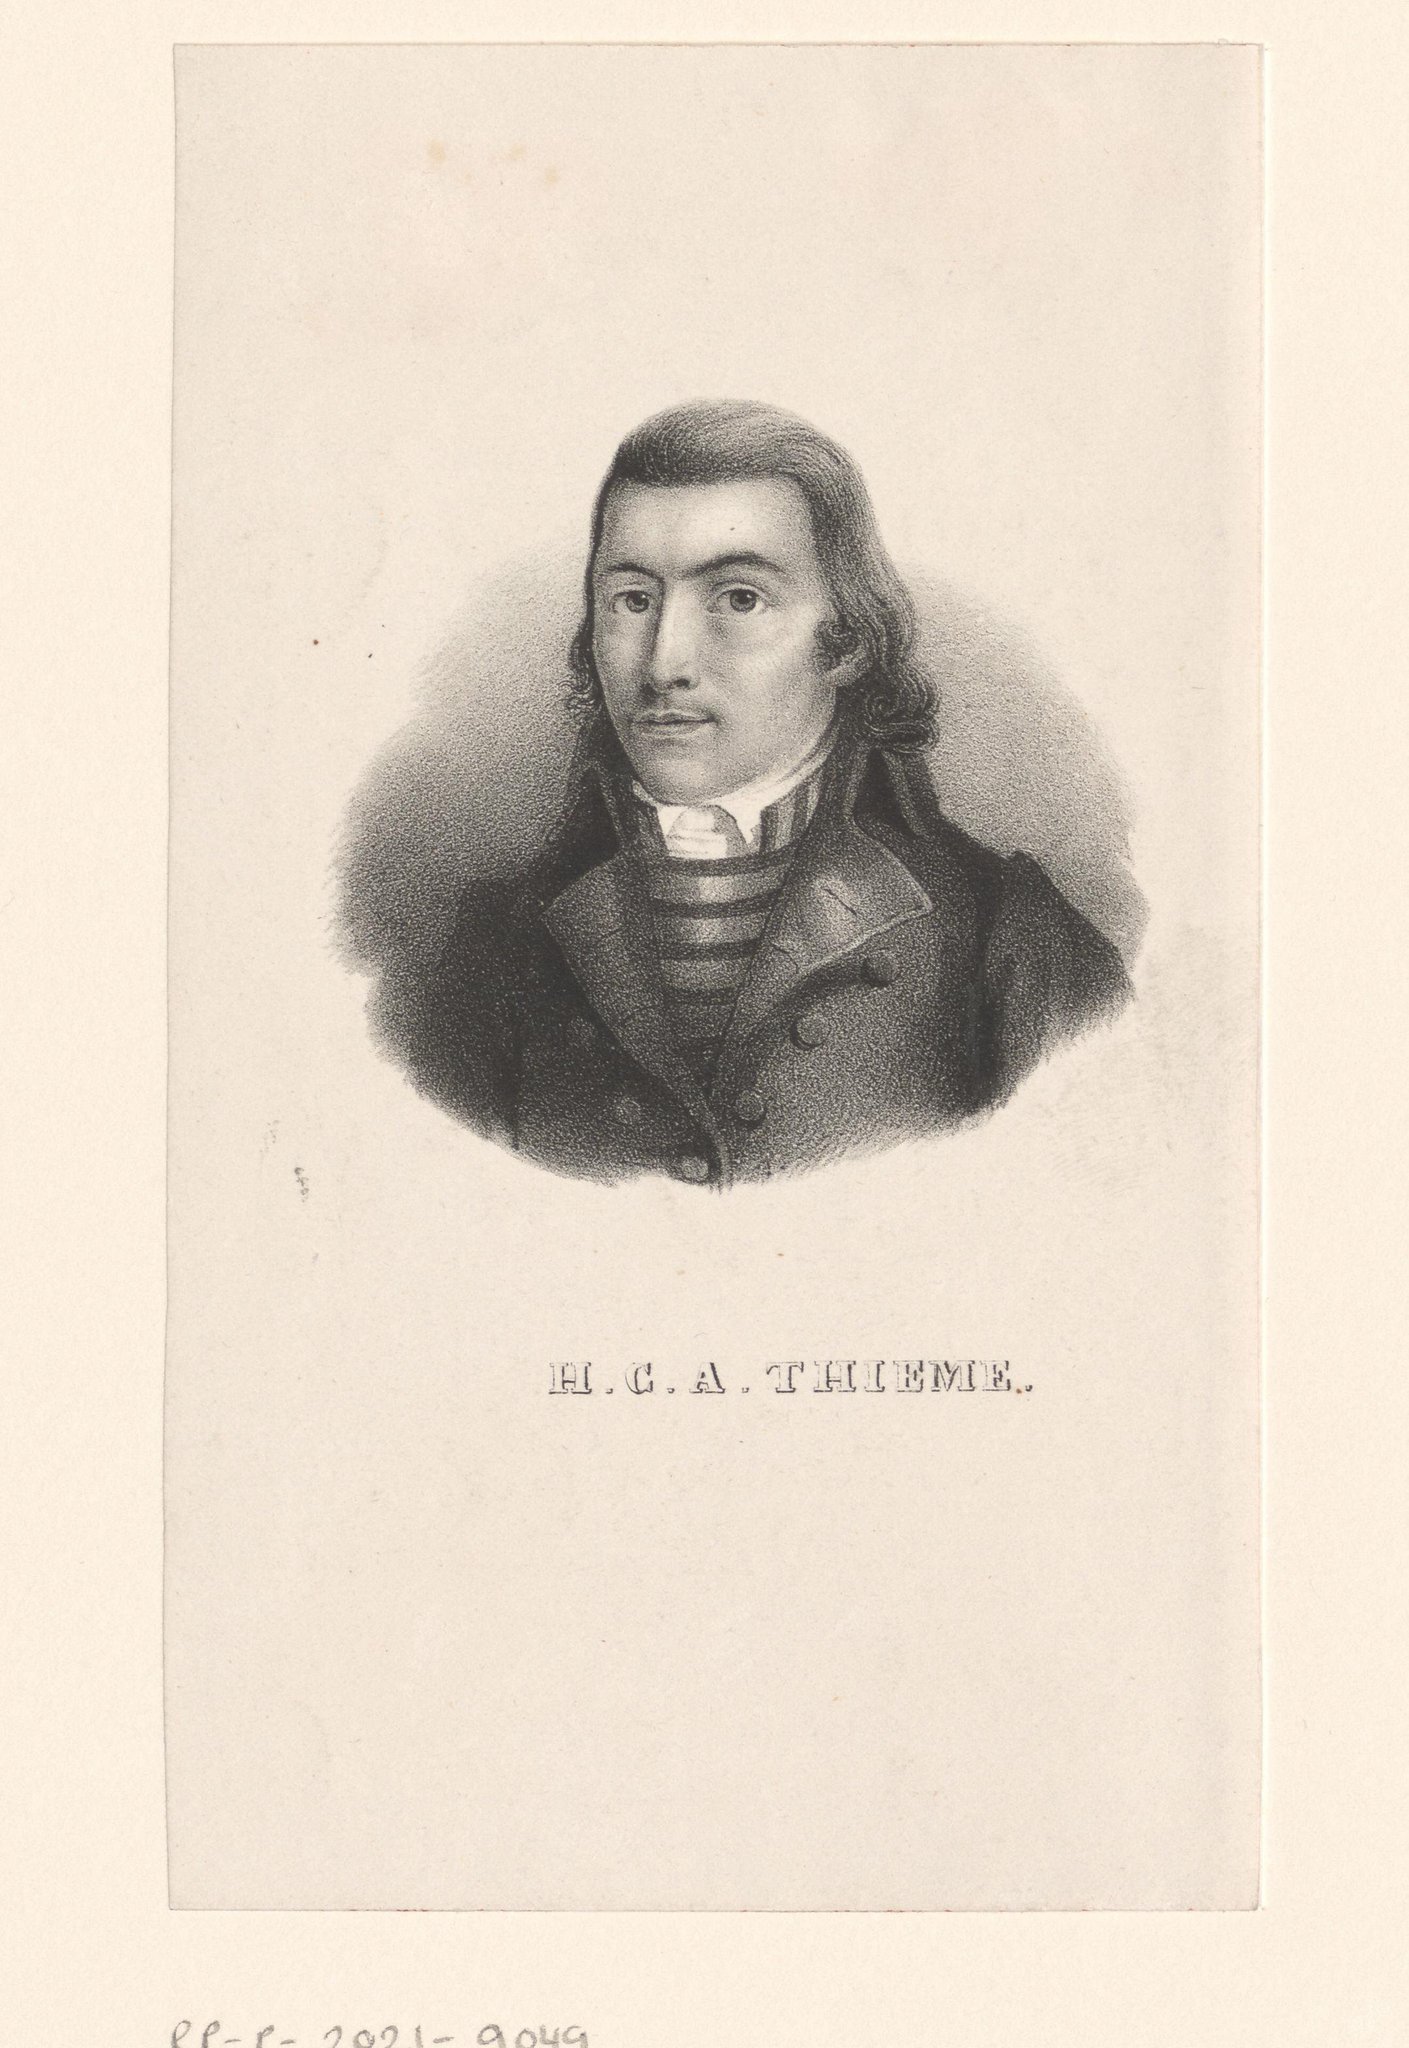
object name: print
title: Portret van Herman Carl Anton Thieme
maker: Anonymous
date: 1820-1850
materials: paper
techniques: lithograph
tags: herman carel anton thieme, publishing, publisher (+ portrait of scholar, scientist), historical persons